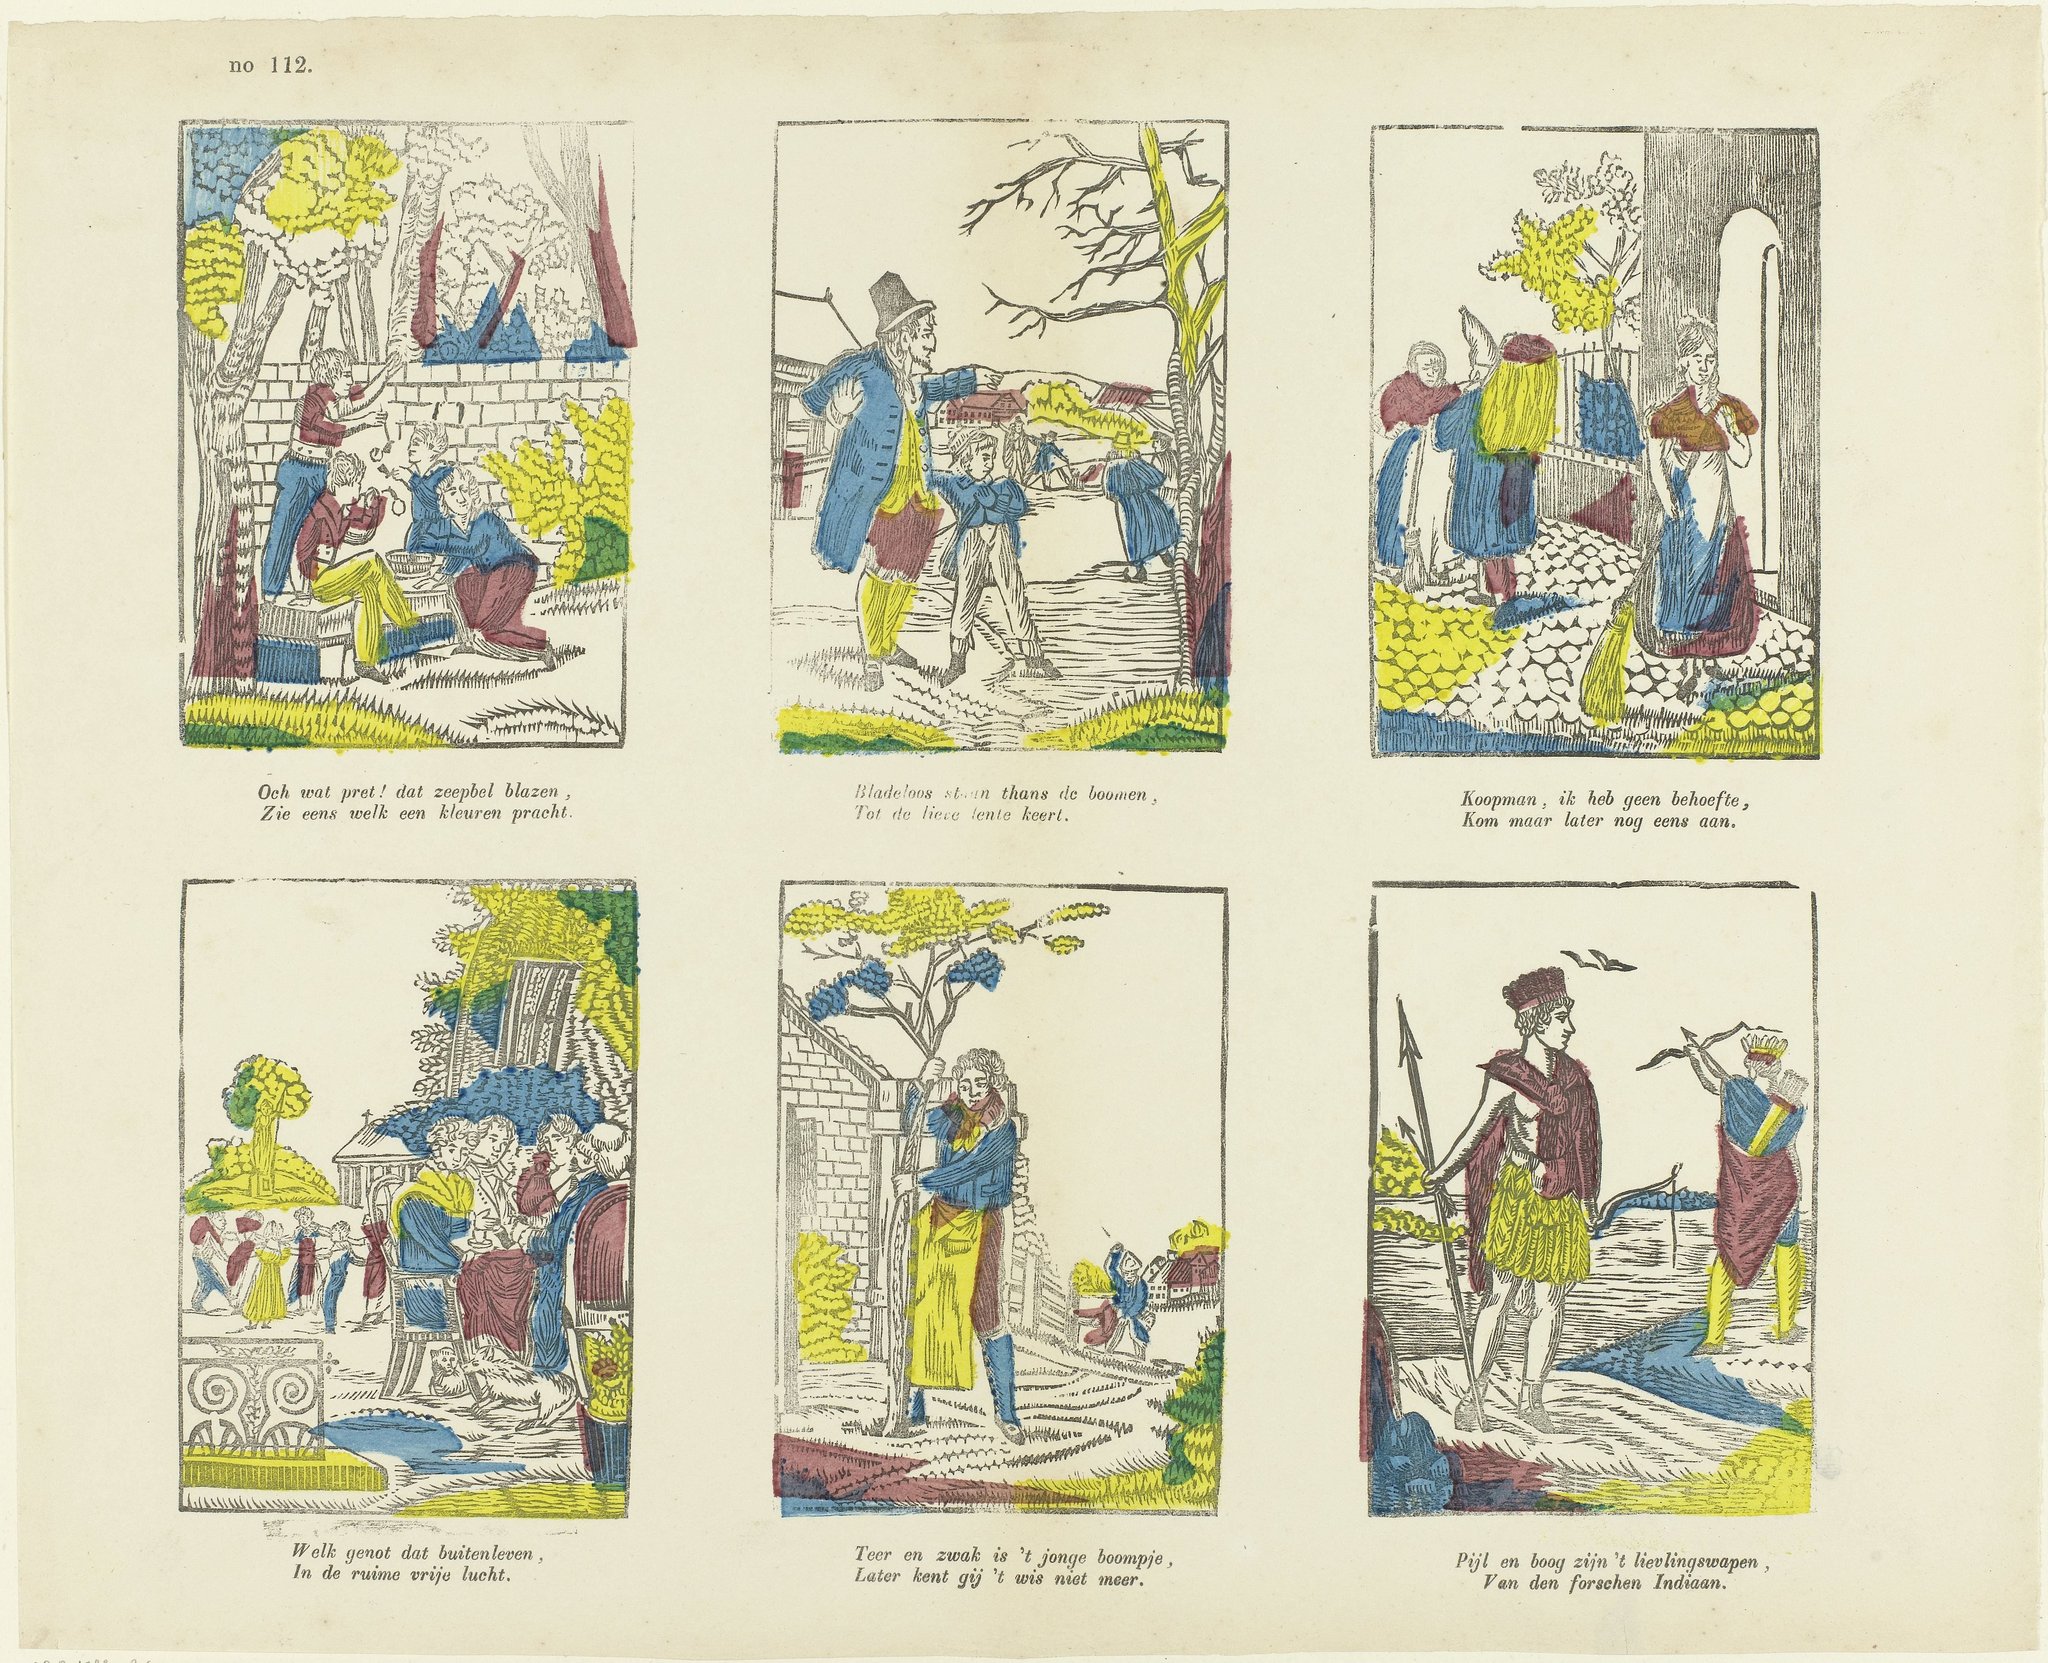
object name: print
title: Kinderspelen en bezigheden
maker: Anonymous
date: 1848-1881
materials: paper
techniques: colour, letterpress printing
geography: netherlands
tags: bubble-blowing (children's games and plays), children's games and plays, dancing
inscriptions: collector's mark: Lugt 2760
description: Blad met 6 voorstellingen van kinderspelen en bezigheden, zoals bellenblazen, wandelen en dansen. Onder elke afbeelding een tweeregelig vers. Genummerd linksboven: no 112.